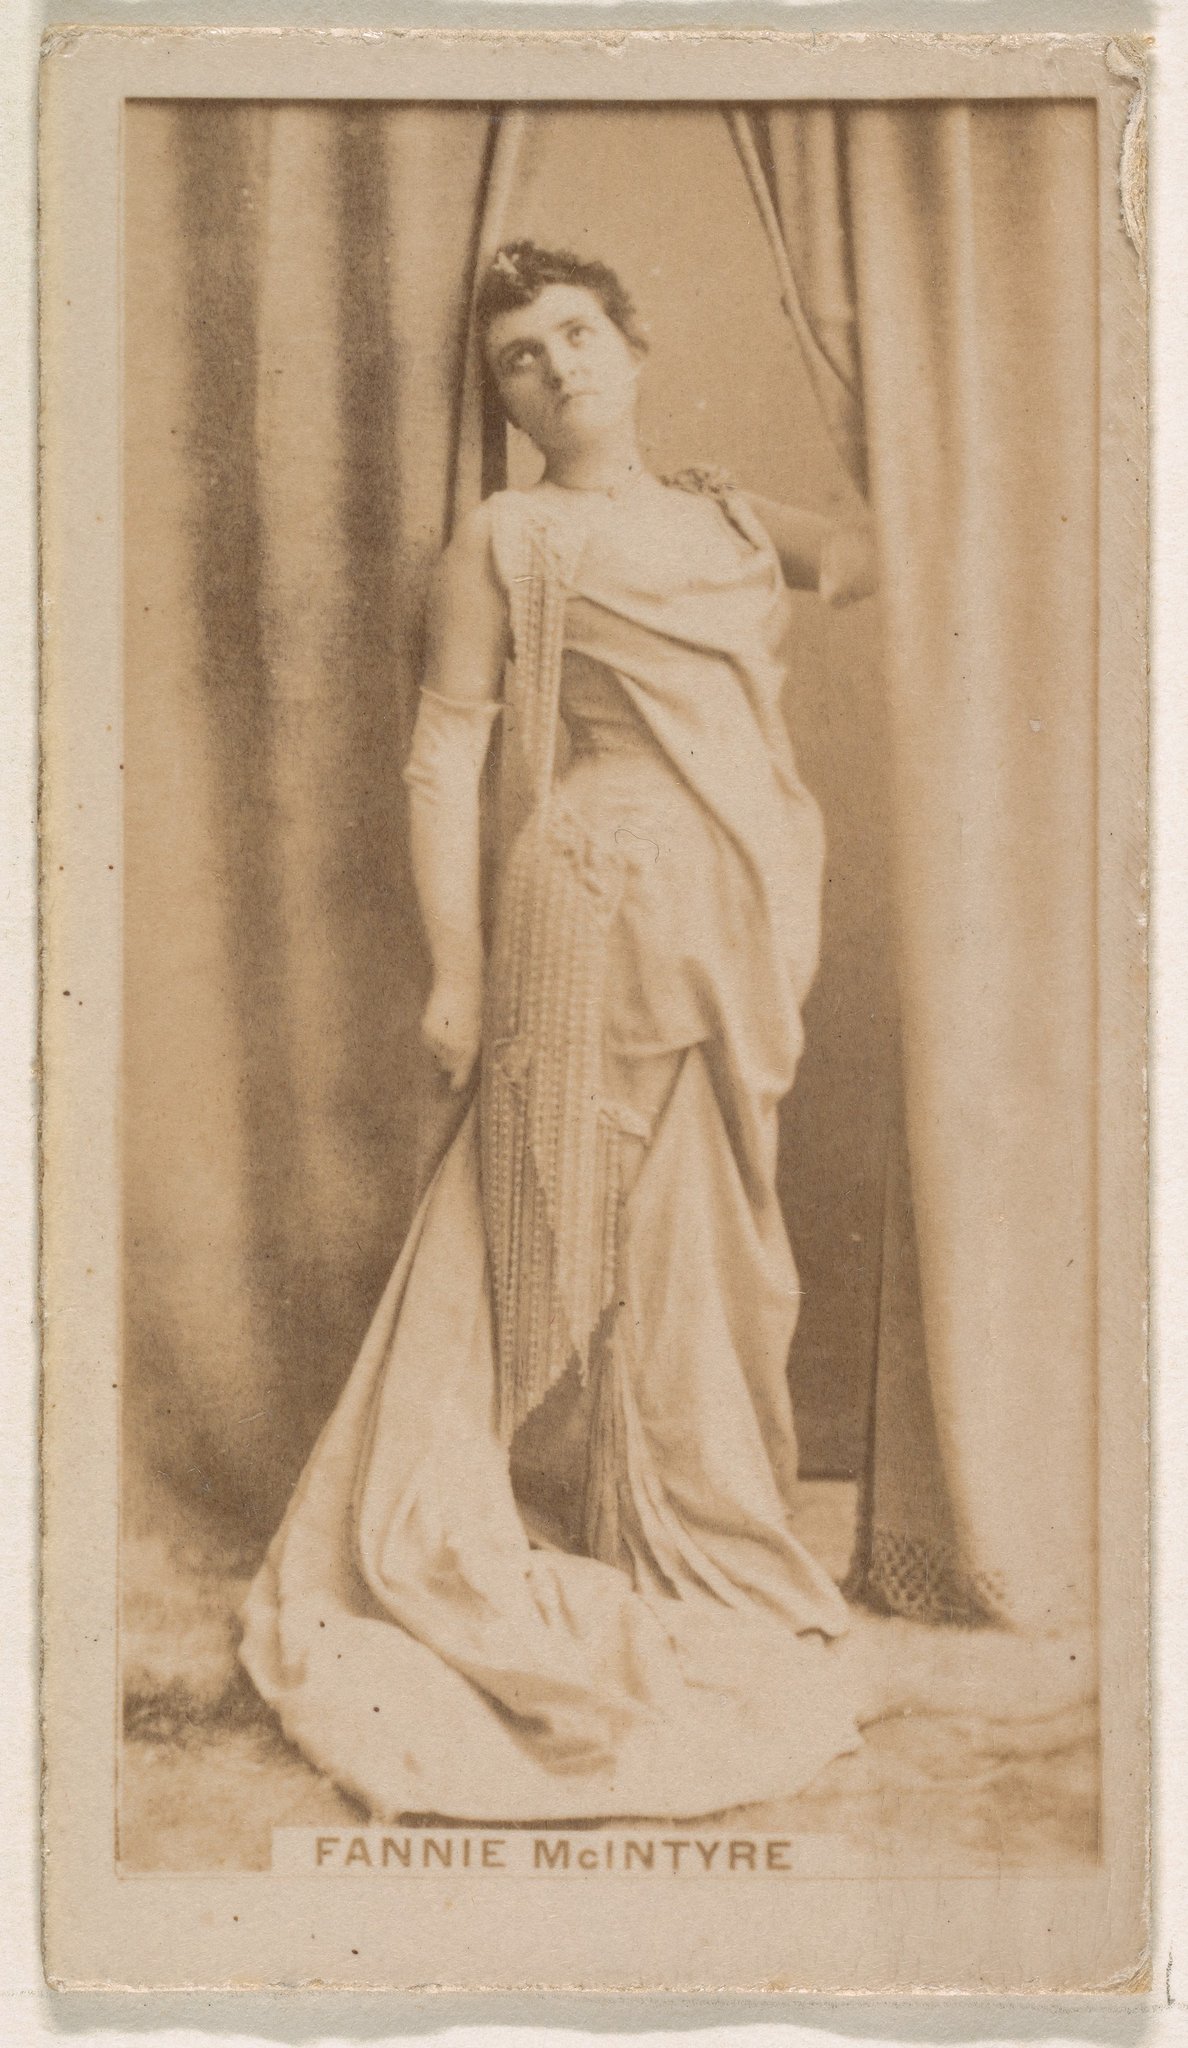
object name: photograph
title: Fannie McIntyre, from the Actresses series (N245) issued by Kinney Brothers to promote Sweet Caporal Cigarettes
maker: kinney brothers tobacco company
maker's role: publisher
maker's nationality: american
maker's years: 1869-2011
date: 1890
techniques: albumen silver print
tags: portraits,women,actresses